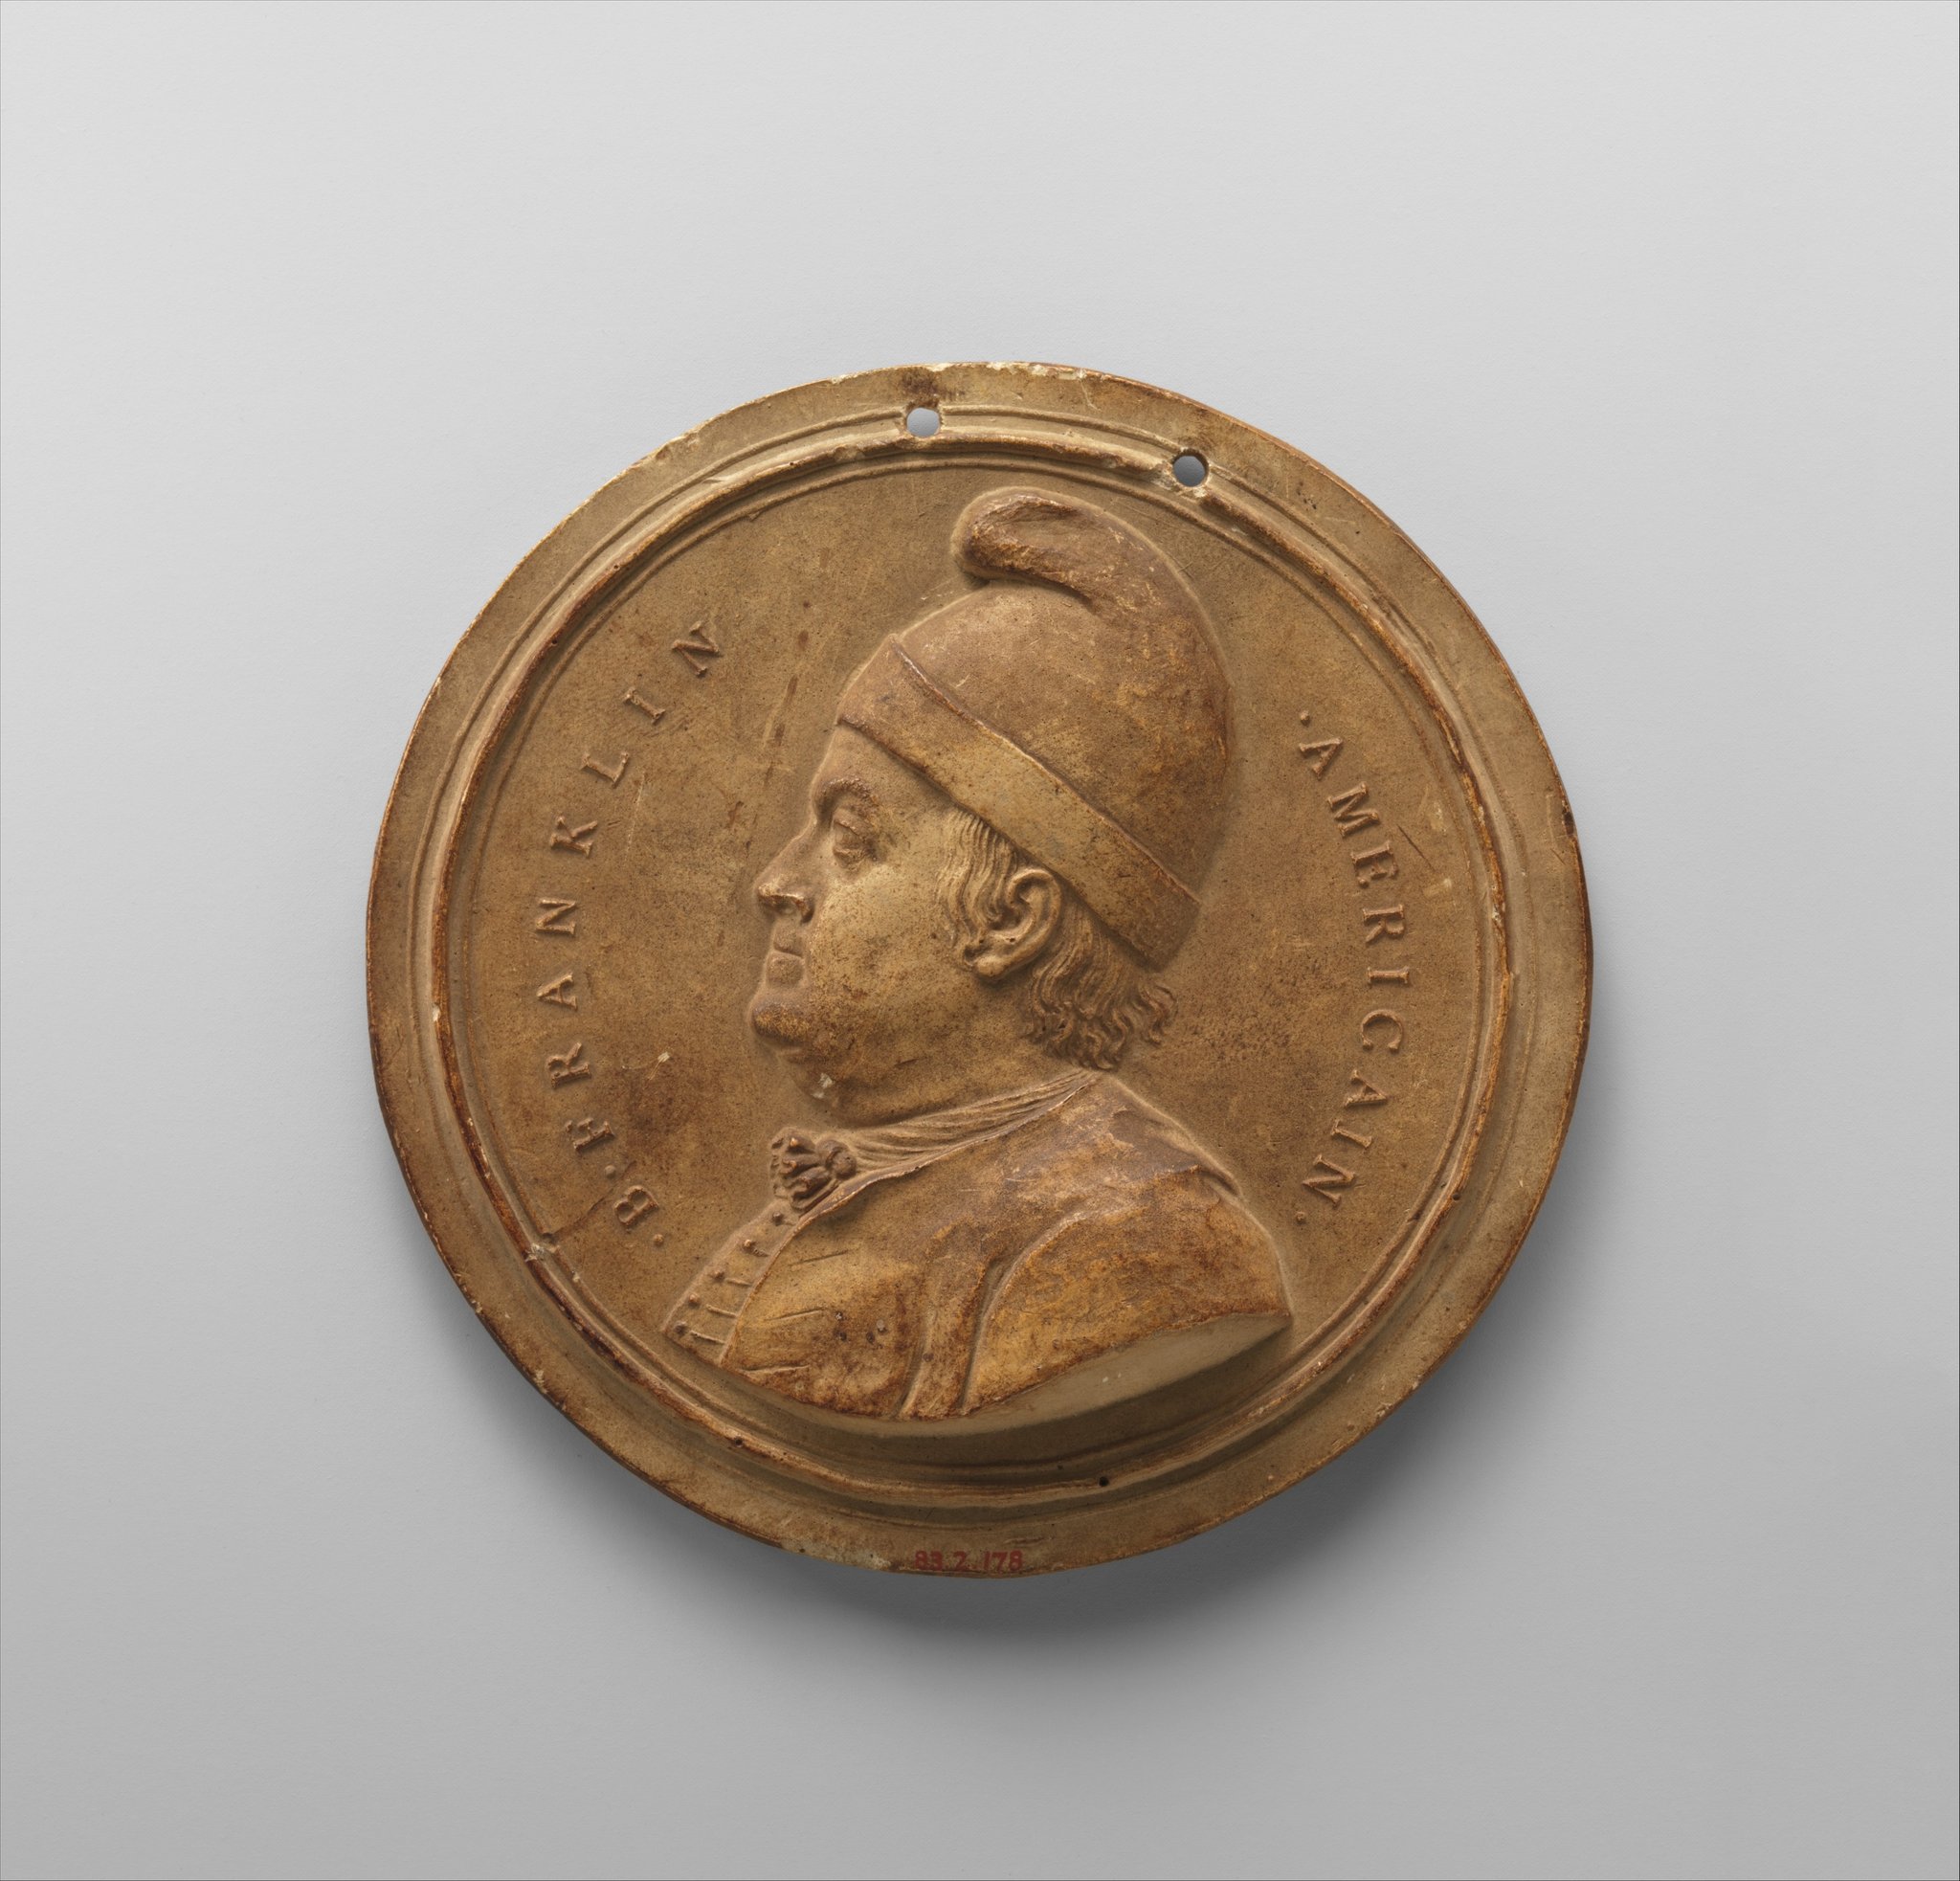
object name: medallion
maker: jean-baptiste nini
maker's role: maker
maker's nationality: italian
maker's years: 1717-1786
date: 1776-1800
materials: ceramic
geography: france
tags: men,profiles